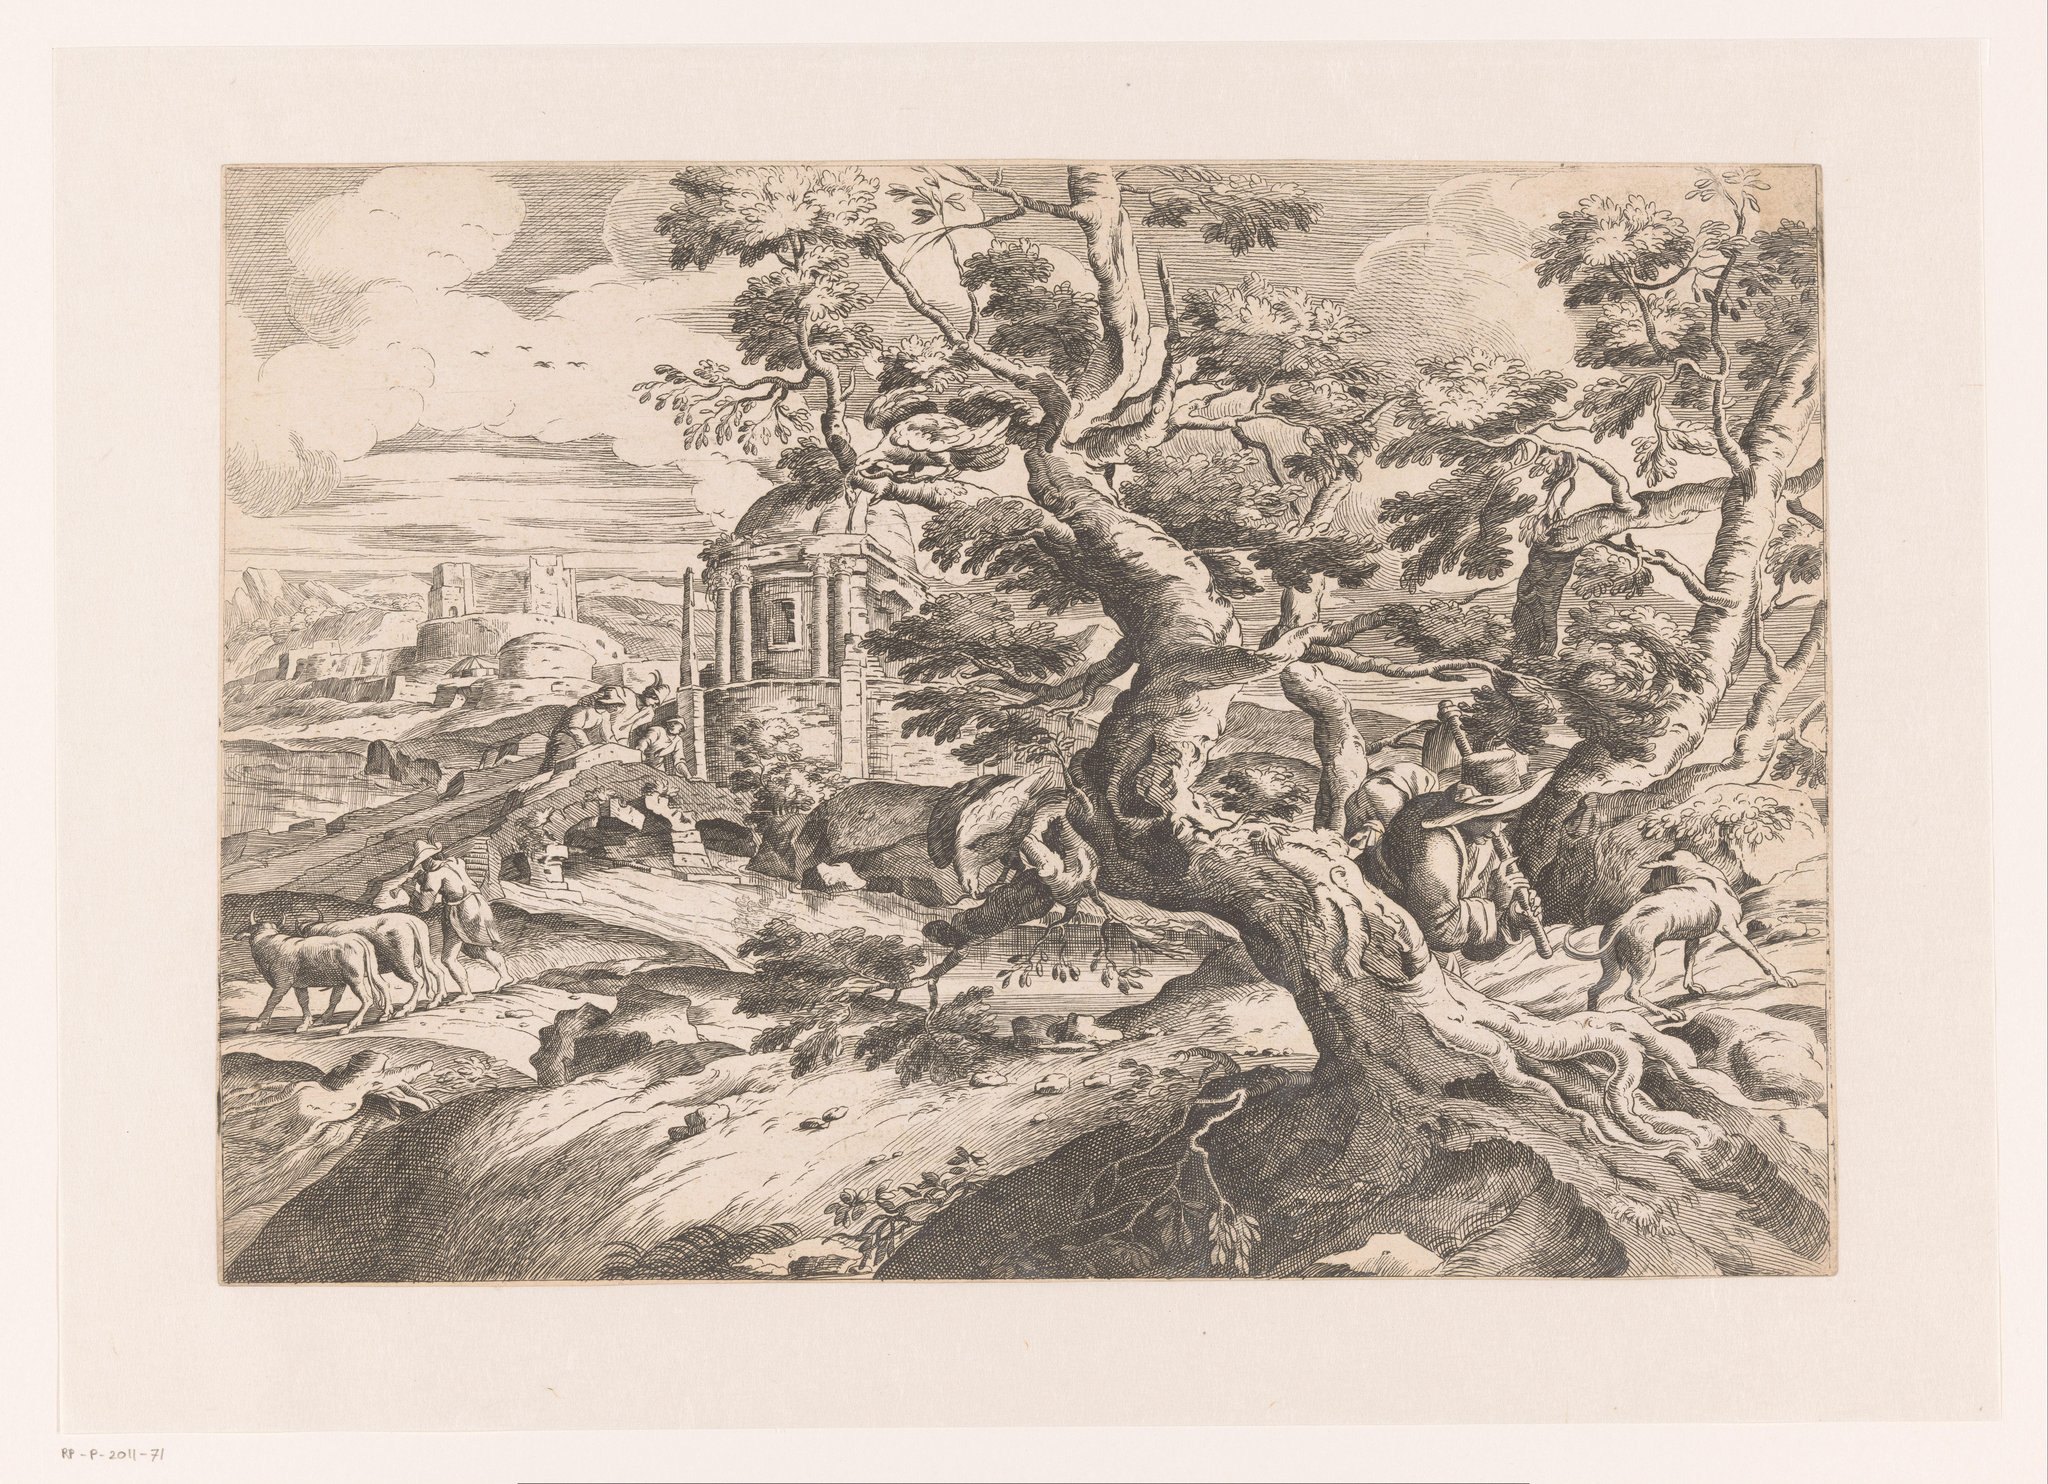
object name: print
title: Landschap met reiziger bij een boom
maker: charles macé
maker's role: draughtsman, print maker, sculptor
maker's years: 1631-1665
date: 1663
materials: paper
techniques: etching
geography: france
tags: trees, landscape with ruins, 'en route', traveller under way, landscapes in the temperate zone (+ landscape with figures, staffage)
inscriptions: collector's mark: Lugt 2760, collector's mark: Lugt 2228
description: Landschap met rechts van het midden een grillige boom; rechts daarvan loopt een reiziger met knapzak en een hond. In de bomen twee vogels met een tak in hun bek. Op de achtergrond een landschap met antieke bouwsels en een herder.